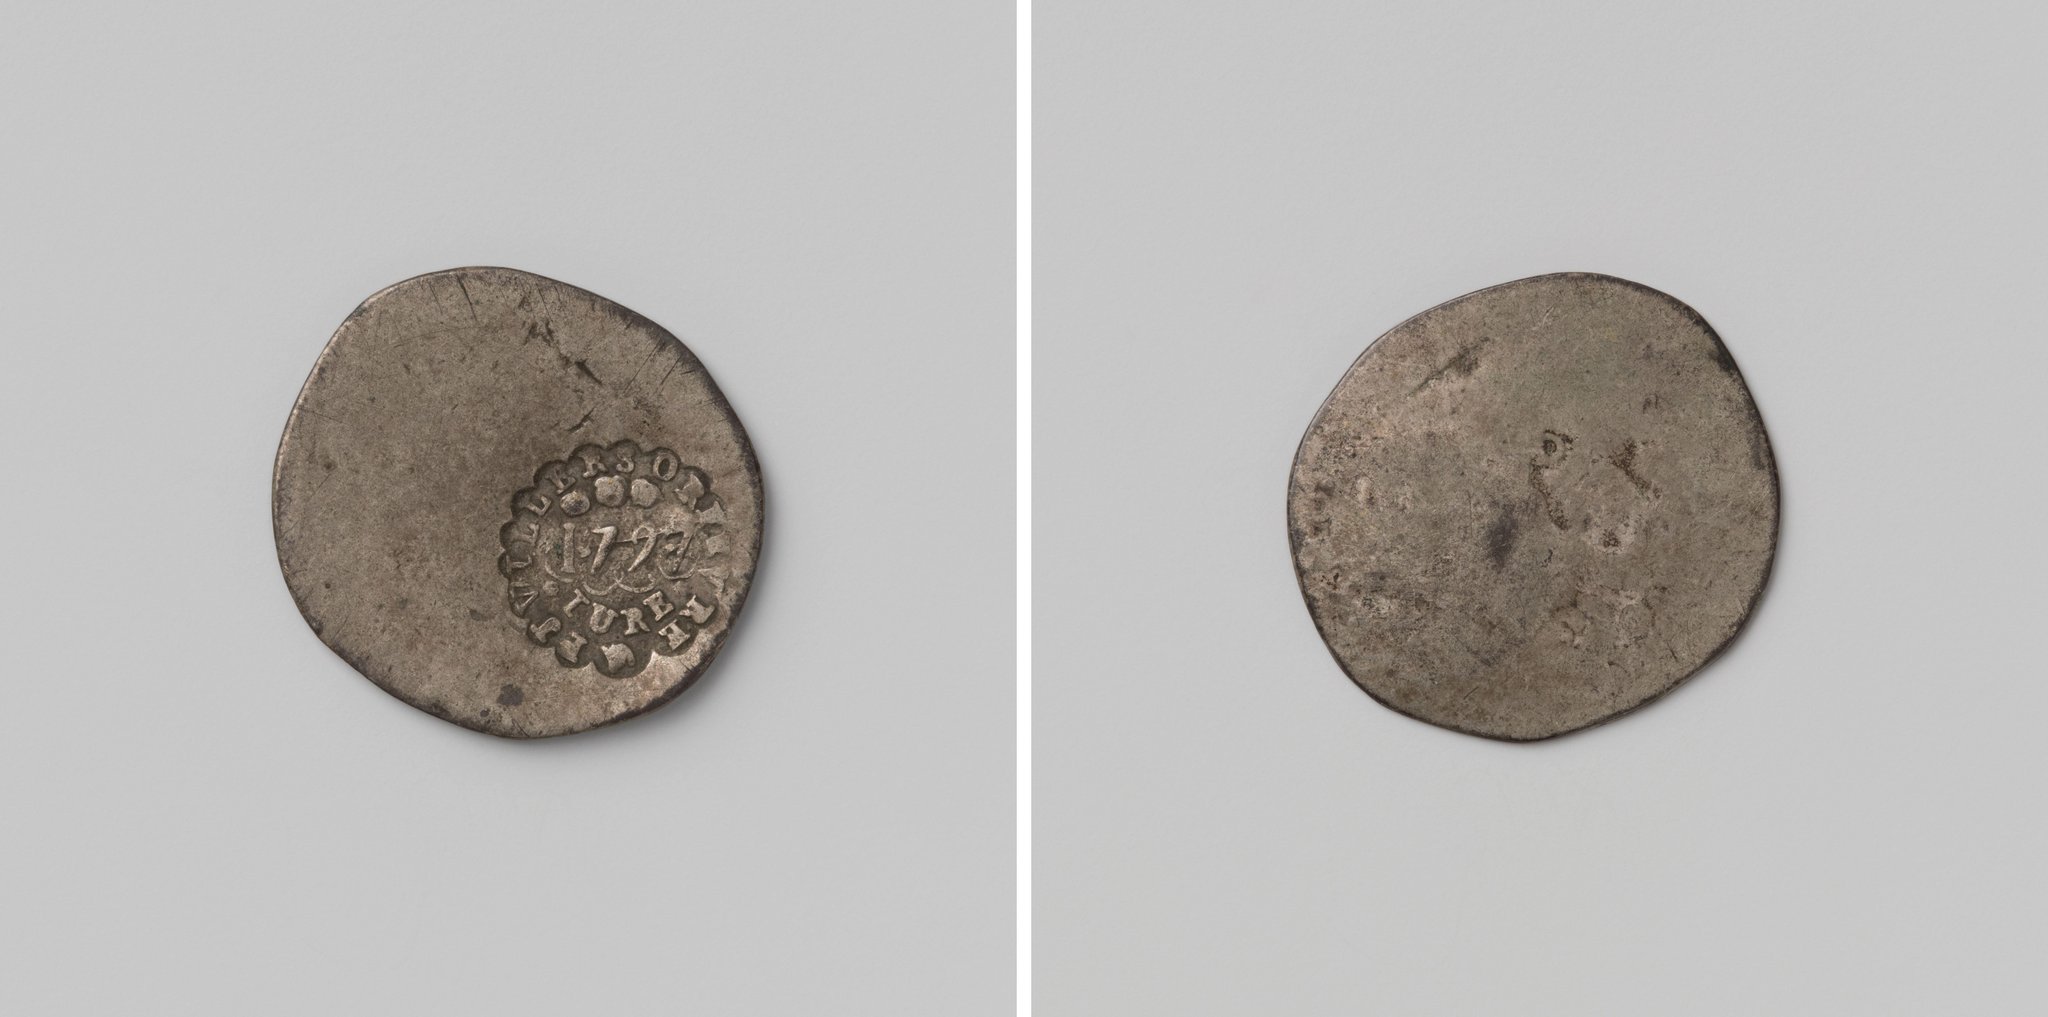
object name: medal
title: Zilversmedengilde van Parijs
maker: Anonymous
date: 1797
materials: silver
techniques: striking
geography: paris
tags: paris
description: Eenzijdig zilveren, niet geheel rond, plaatje met stempel aan rechterzijde. Voorzijde: jaartal binnen omschrift in gekartelde rand. Keerzijde: blanco.